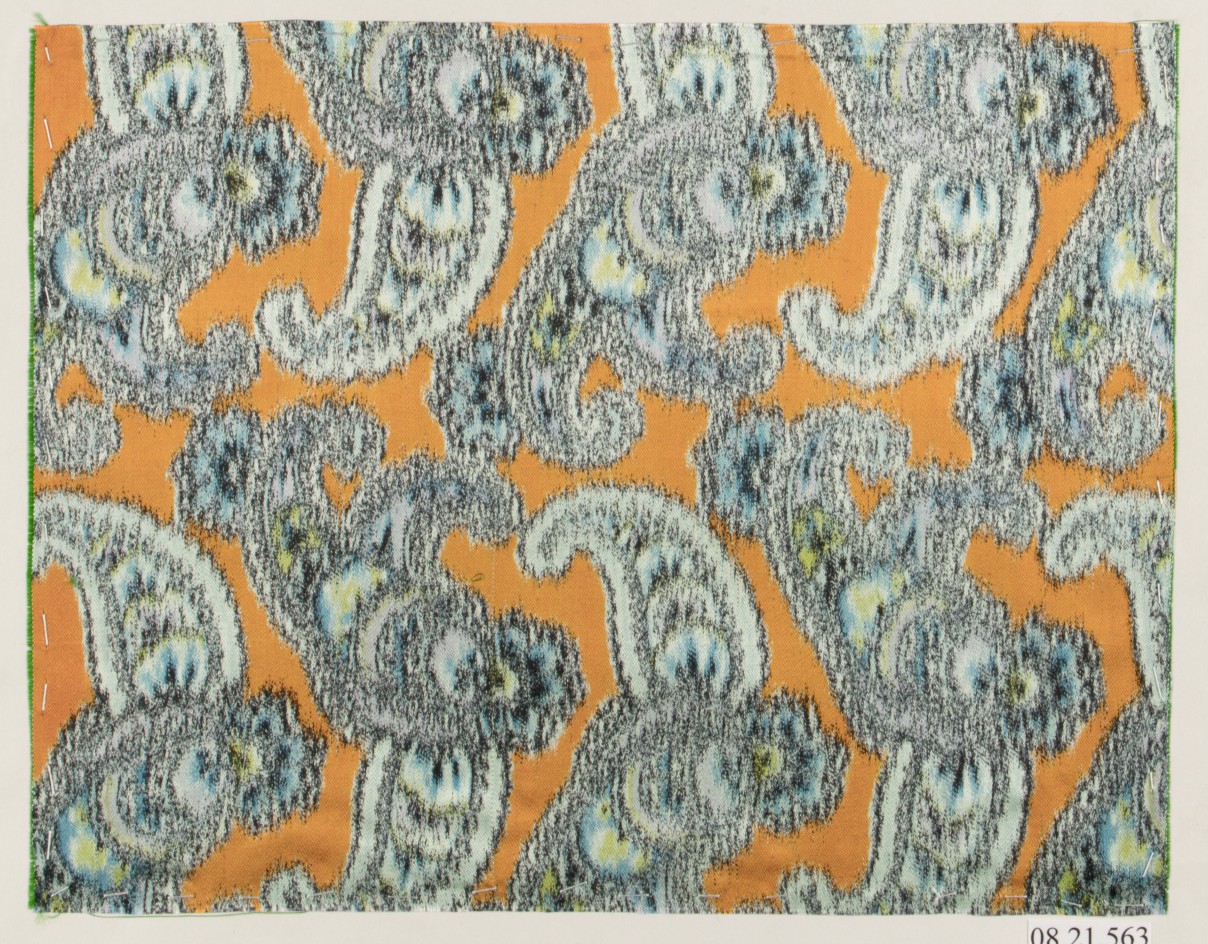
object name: textile sample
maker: Anonymous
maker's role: designer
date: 1900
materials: silk